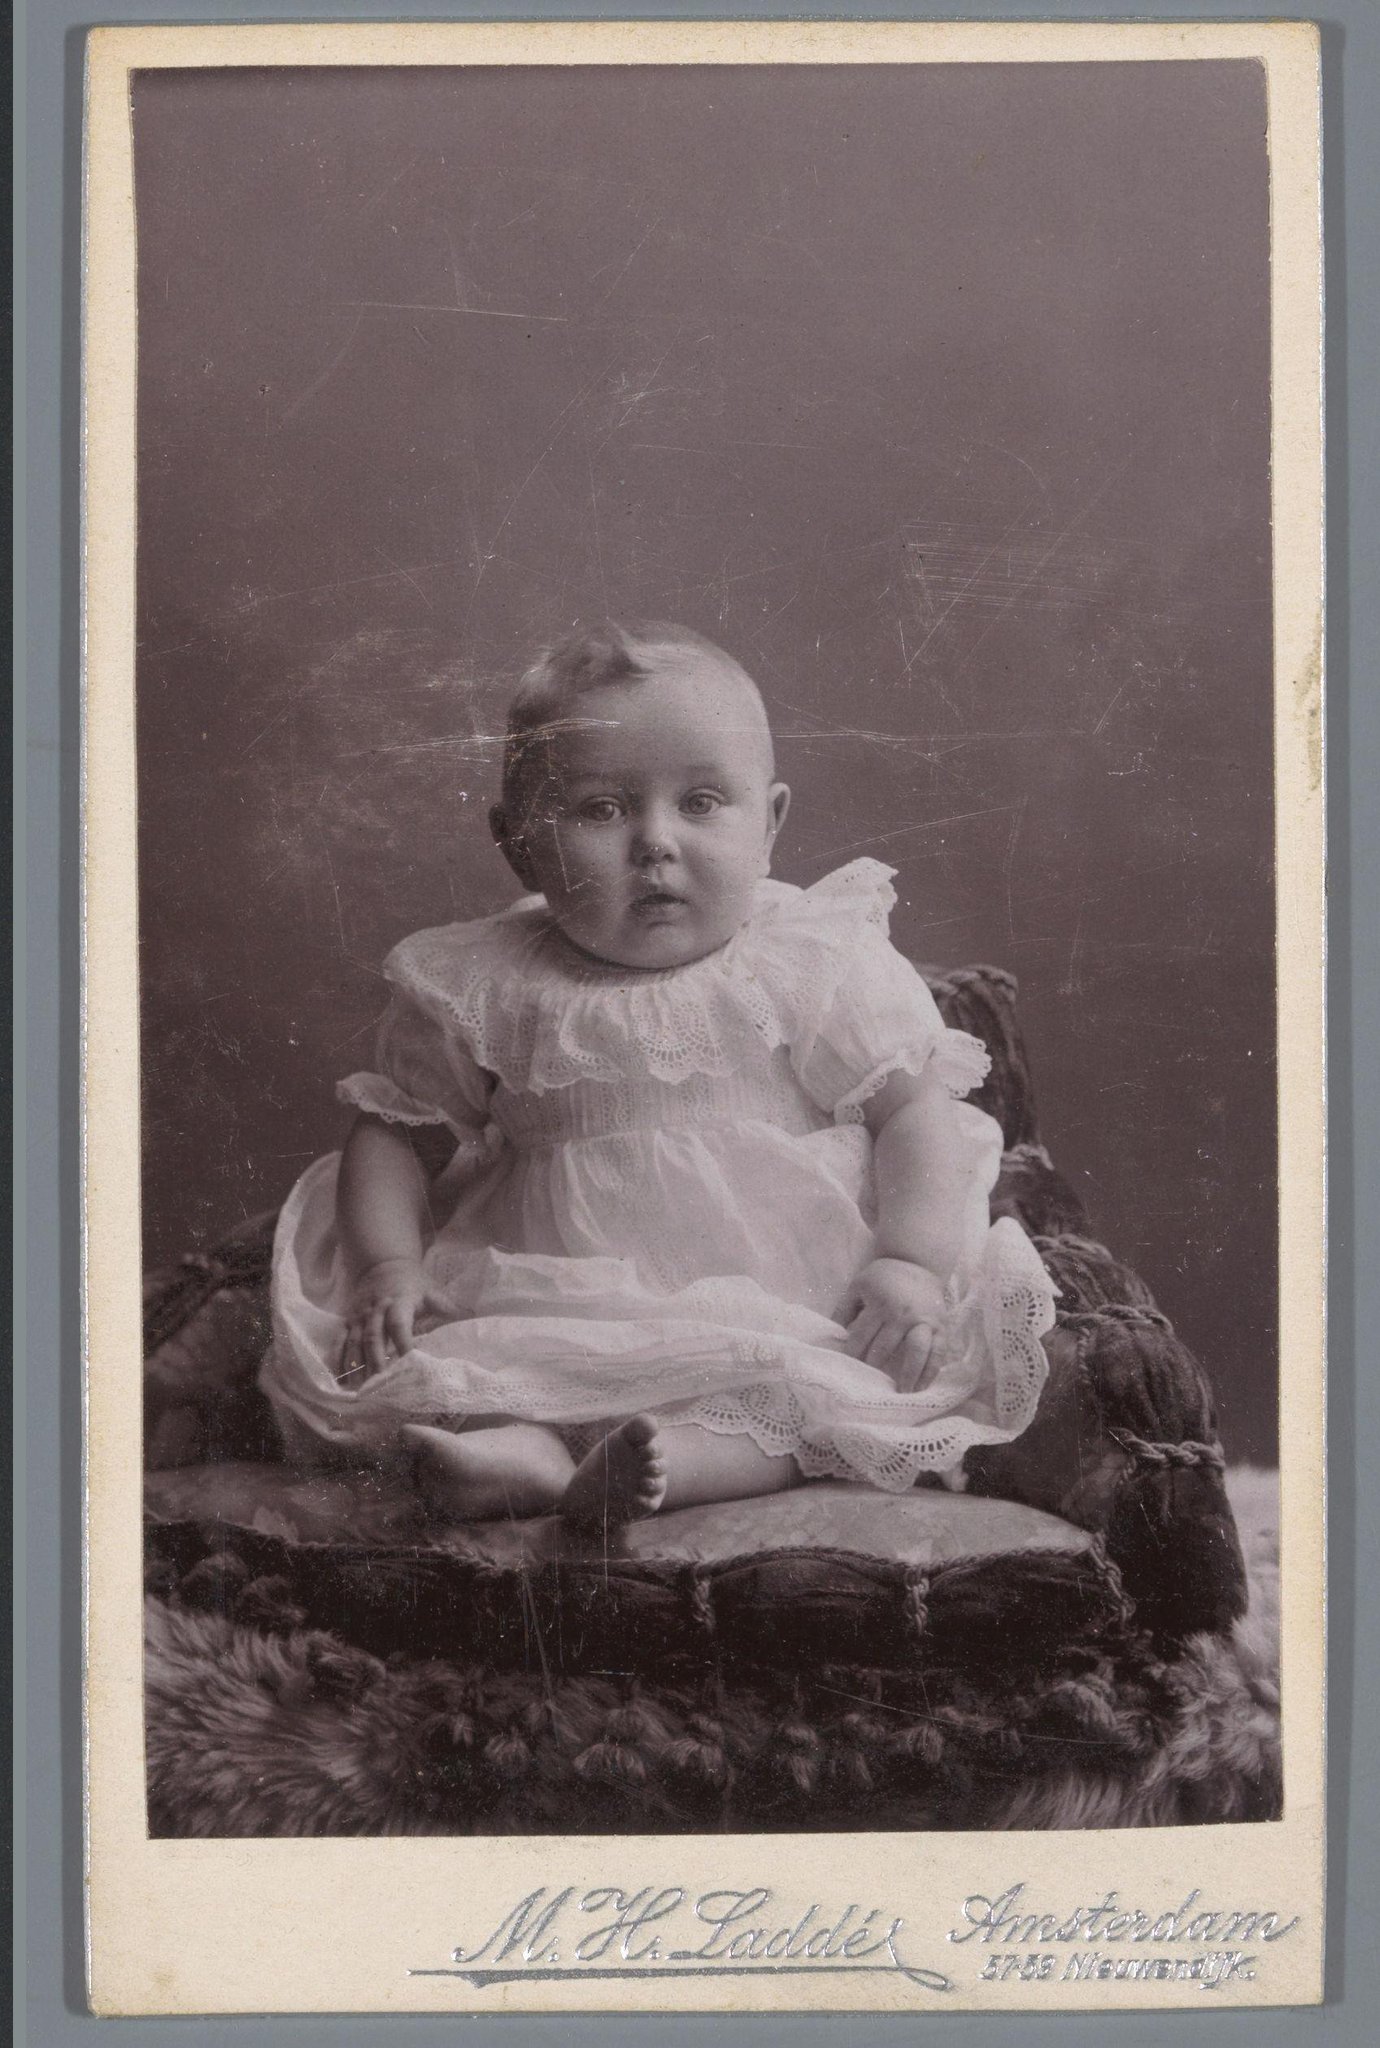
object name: photograph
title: Portret van een onbekende baby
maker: machiel hendricus laddé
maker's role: fotograaf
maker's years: 1866-1932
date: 1892-1906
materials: cardboard, photographic support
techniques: collodion silver print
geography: amsterdam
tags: historical persons, infant, baby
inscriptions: inscription: ‘voor Grietje boon’, address: ‘M. H. Laddé/ Amsterdam/ 57-59 Nieuwendijk.’